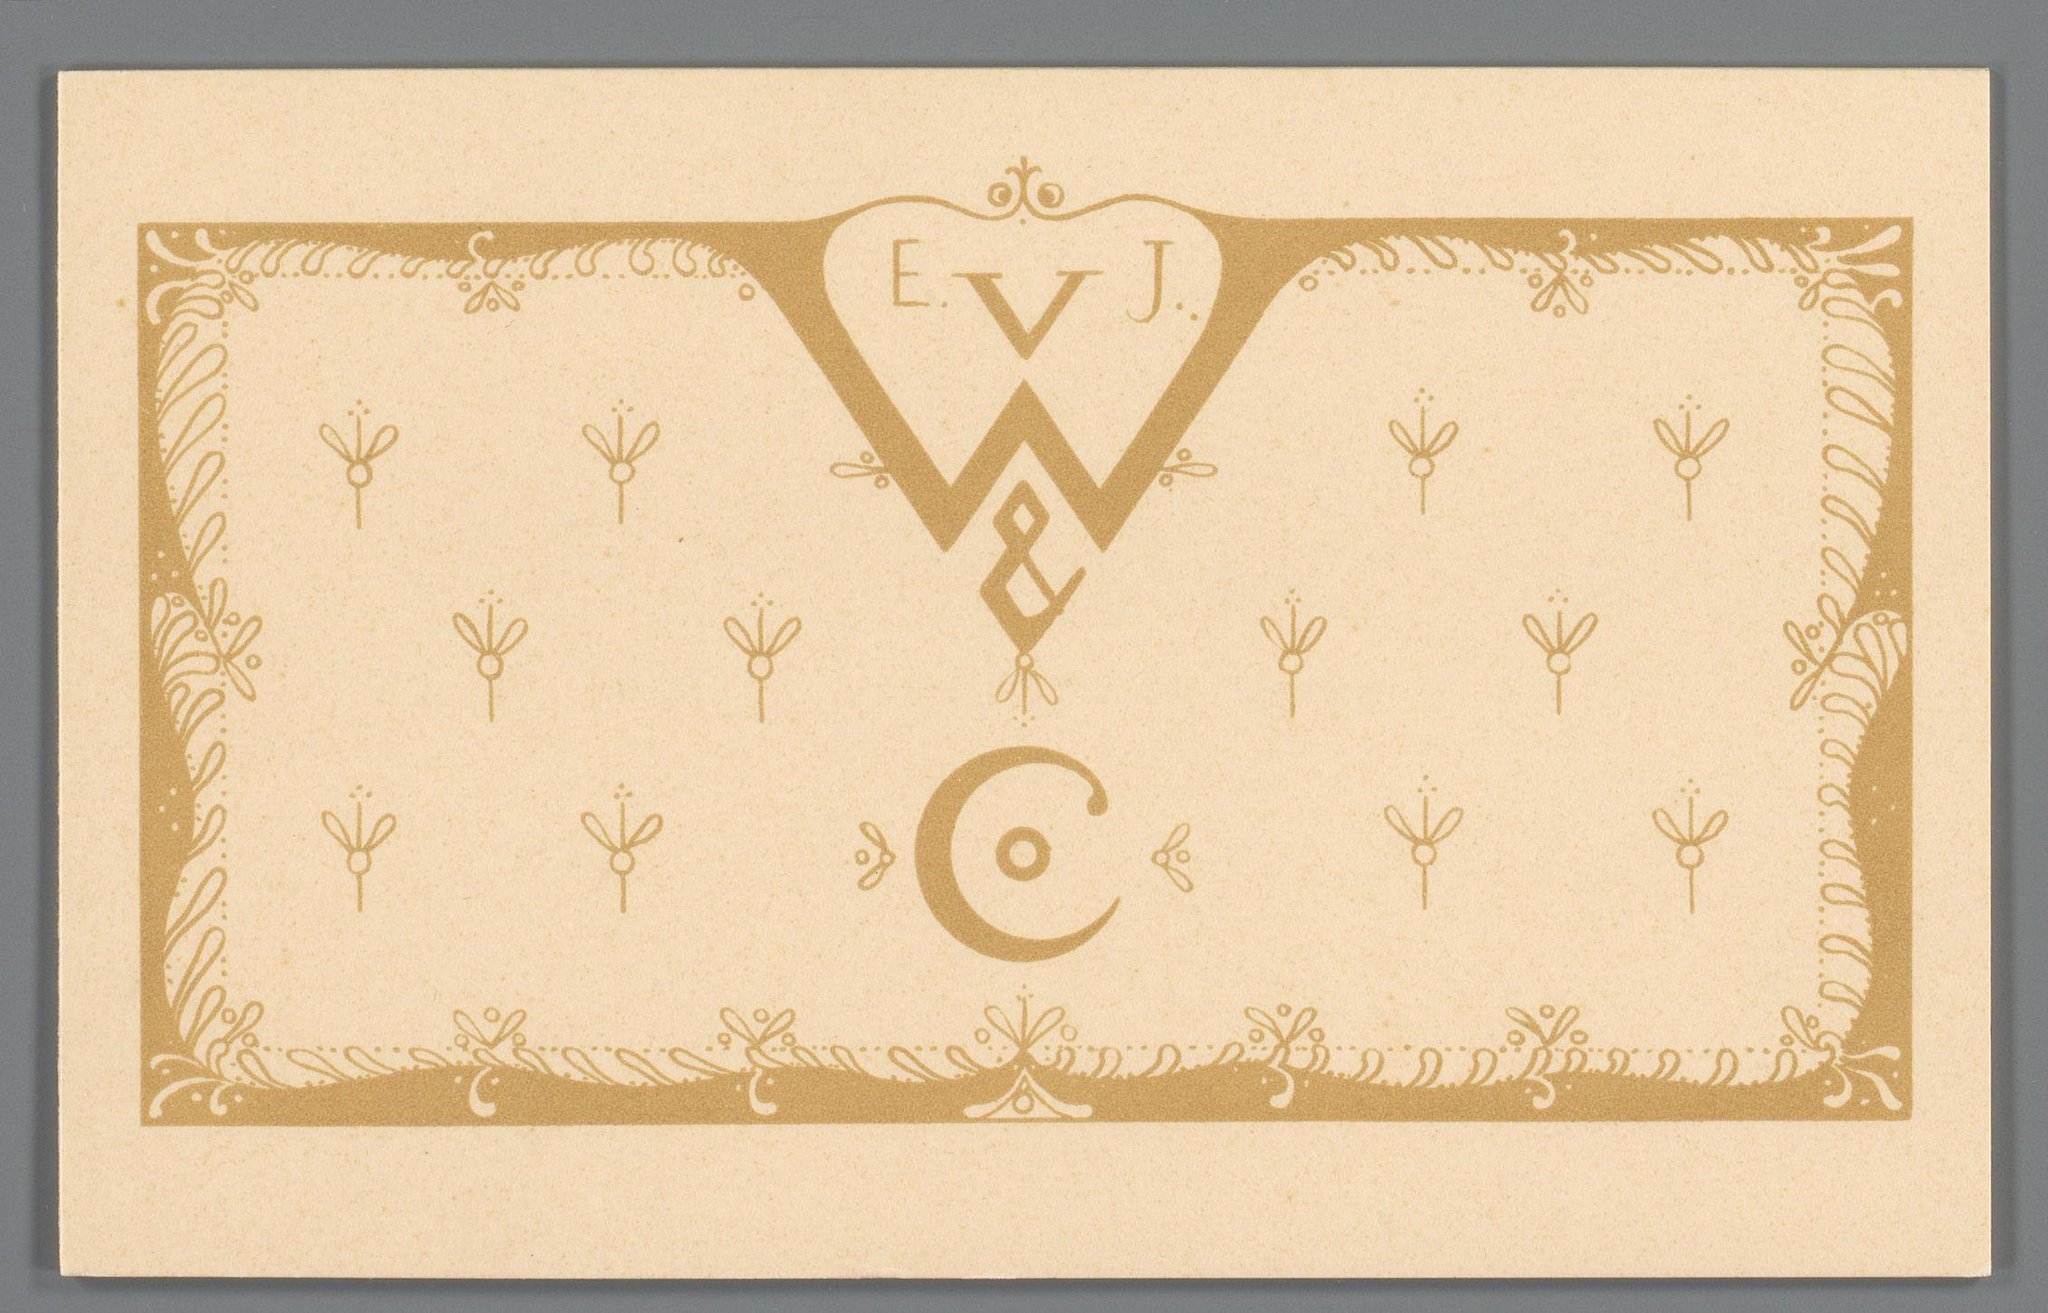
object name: business card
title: Adreskaart van kunsthandel E.J. van Wisselingh & Co.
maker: Anonymous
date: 1907-1915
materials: paper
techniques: letterpress printing, lithograph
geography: amsterdam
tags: abstract, non-representational art, ornaments ~ art, amsterdam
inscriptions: date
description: Op de voor- en achterzijde een herhaalde voorstelling van bloemen in een veld met ornamenteel kader. In het midden daarvan het monogram van de firma 'E.J. v W & Co.'. Binnenin een tekst die aangeeft dat de werkplaatsen zullen verhuizen naar de Prinsengracht 824.